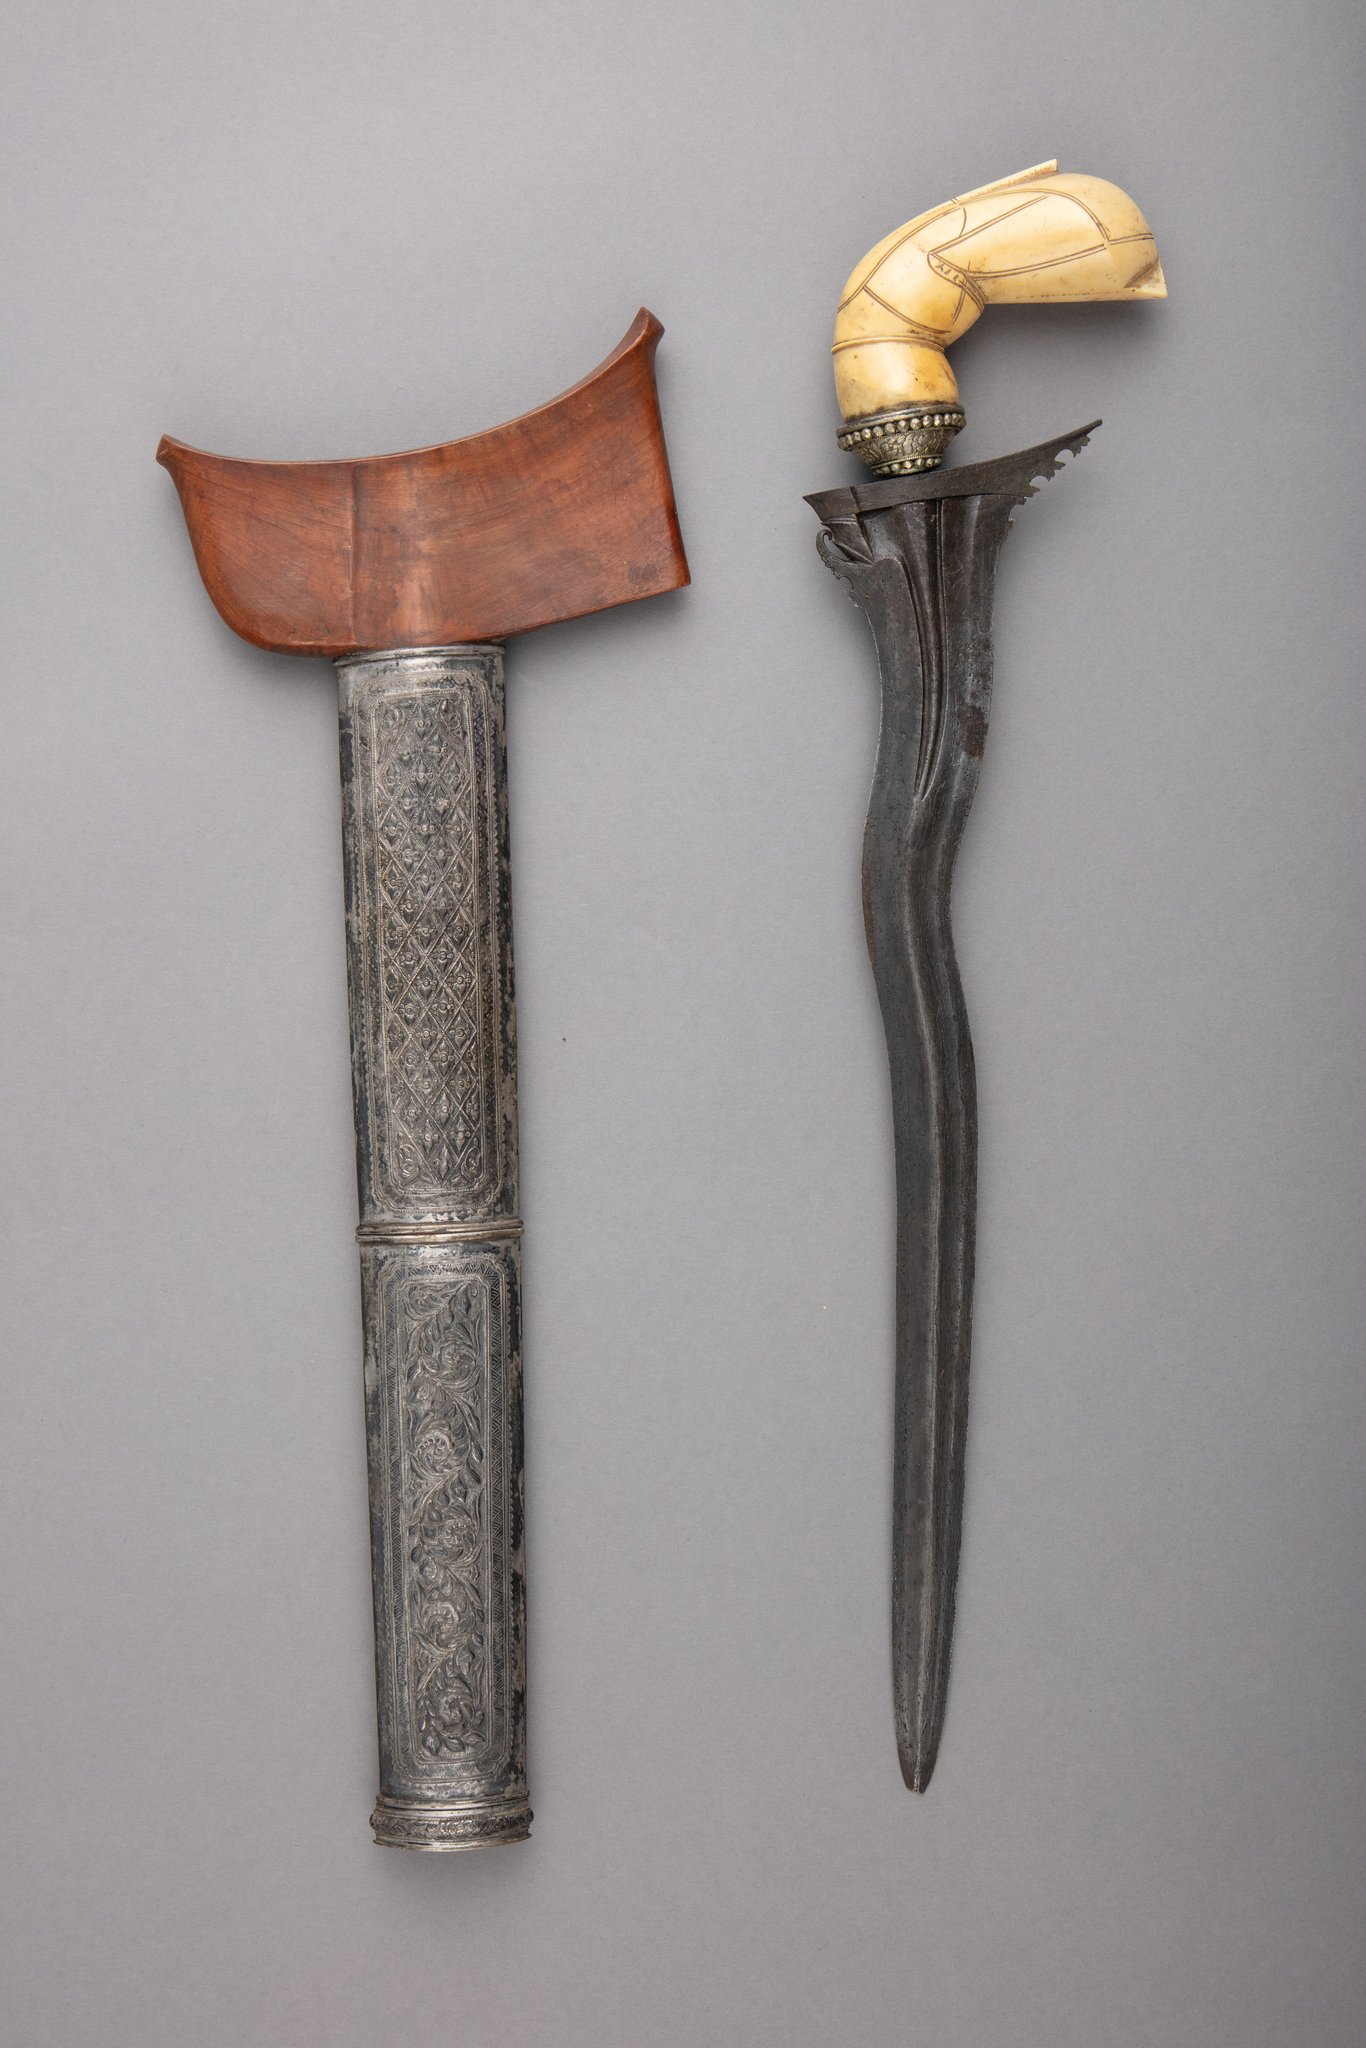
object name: kris with sheath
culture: indonesian, sumbawa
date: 1701-1900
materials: ivory, silver, steel, wood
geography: indonesia